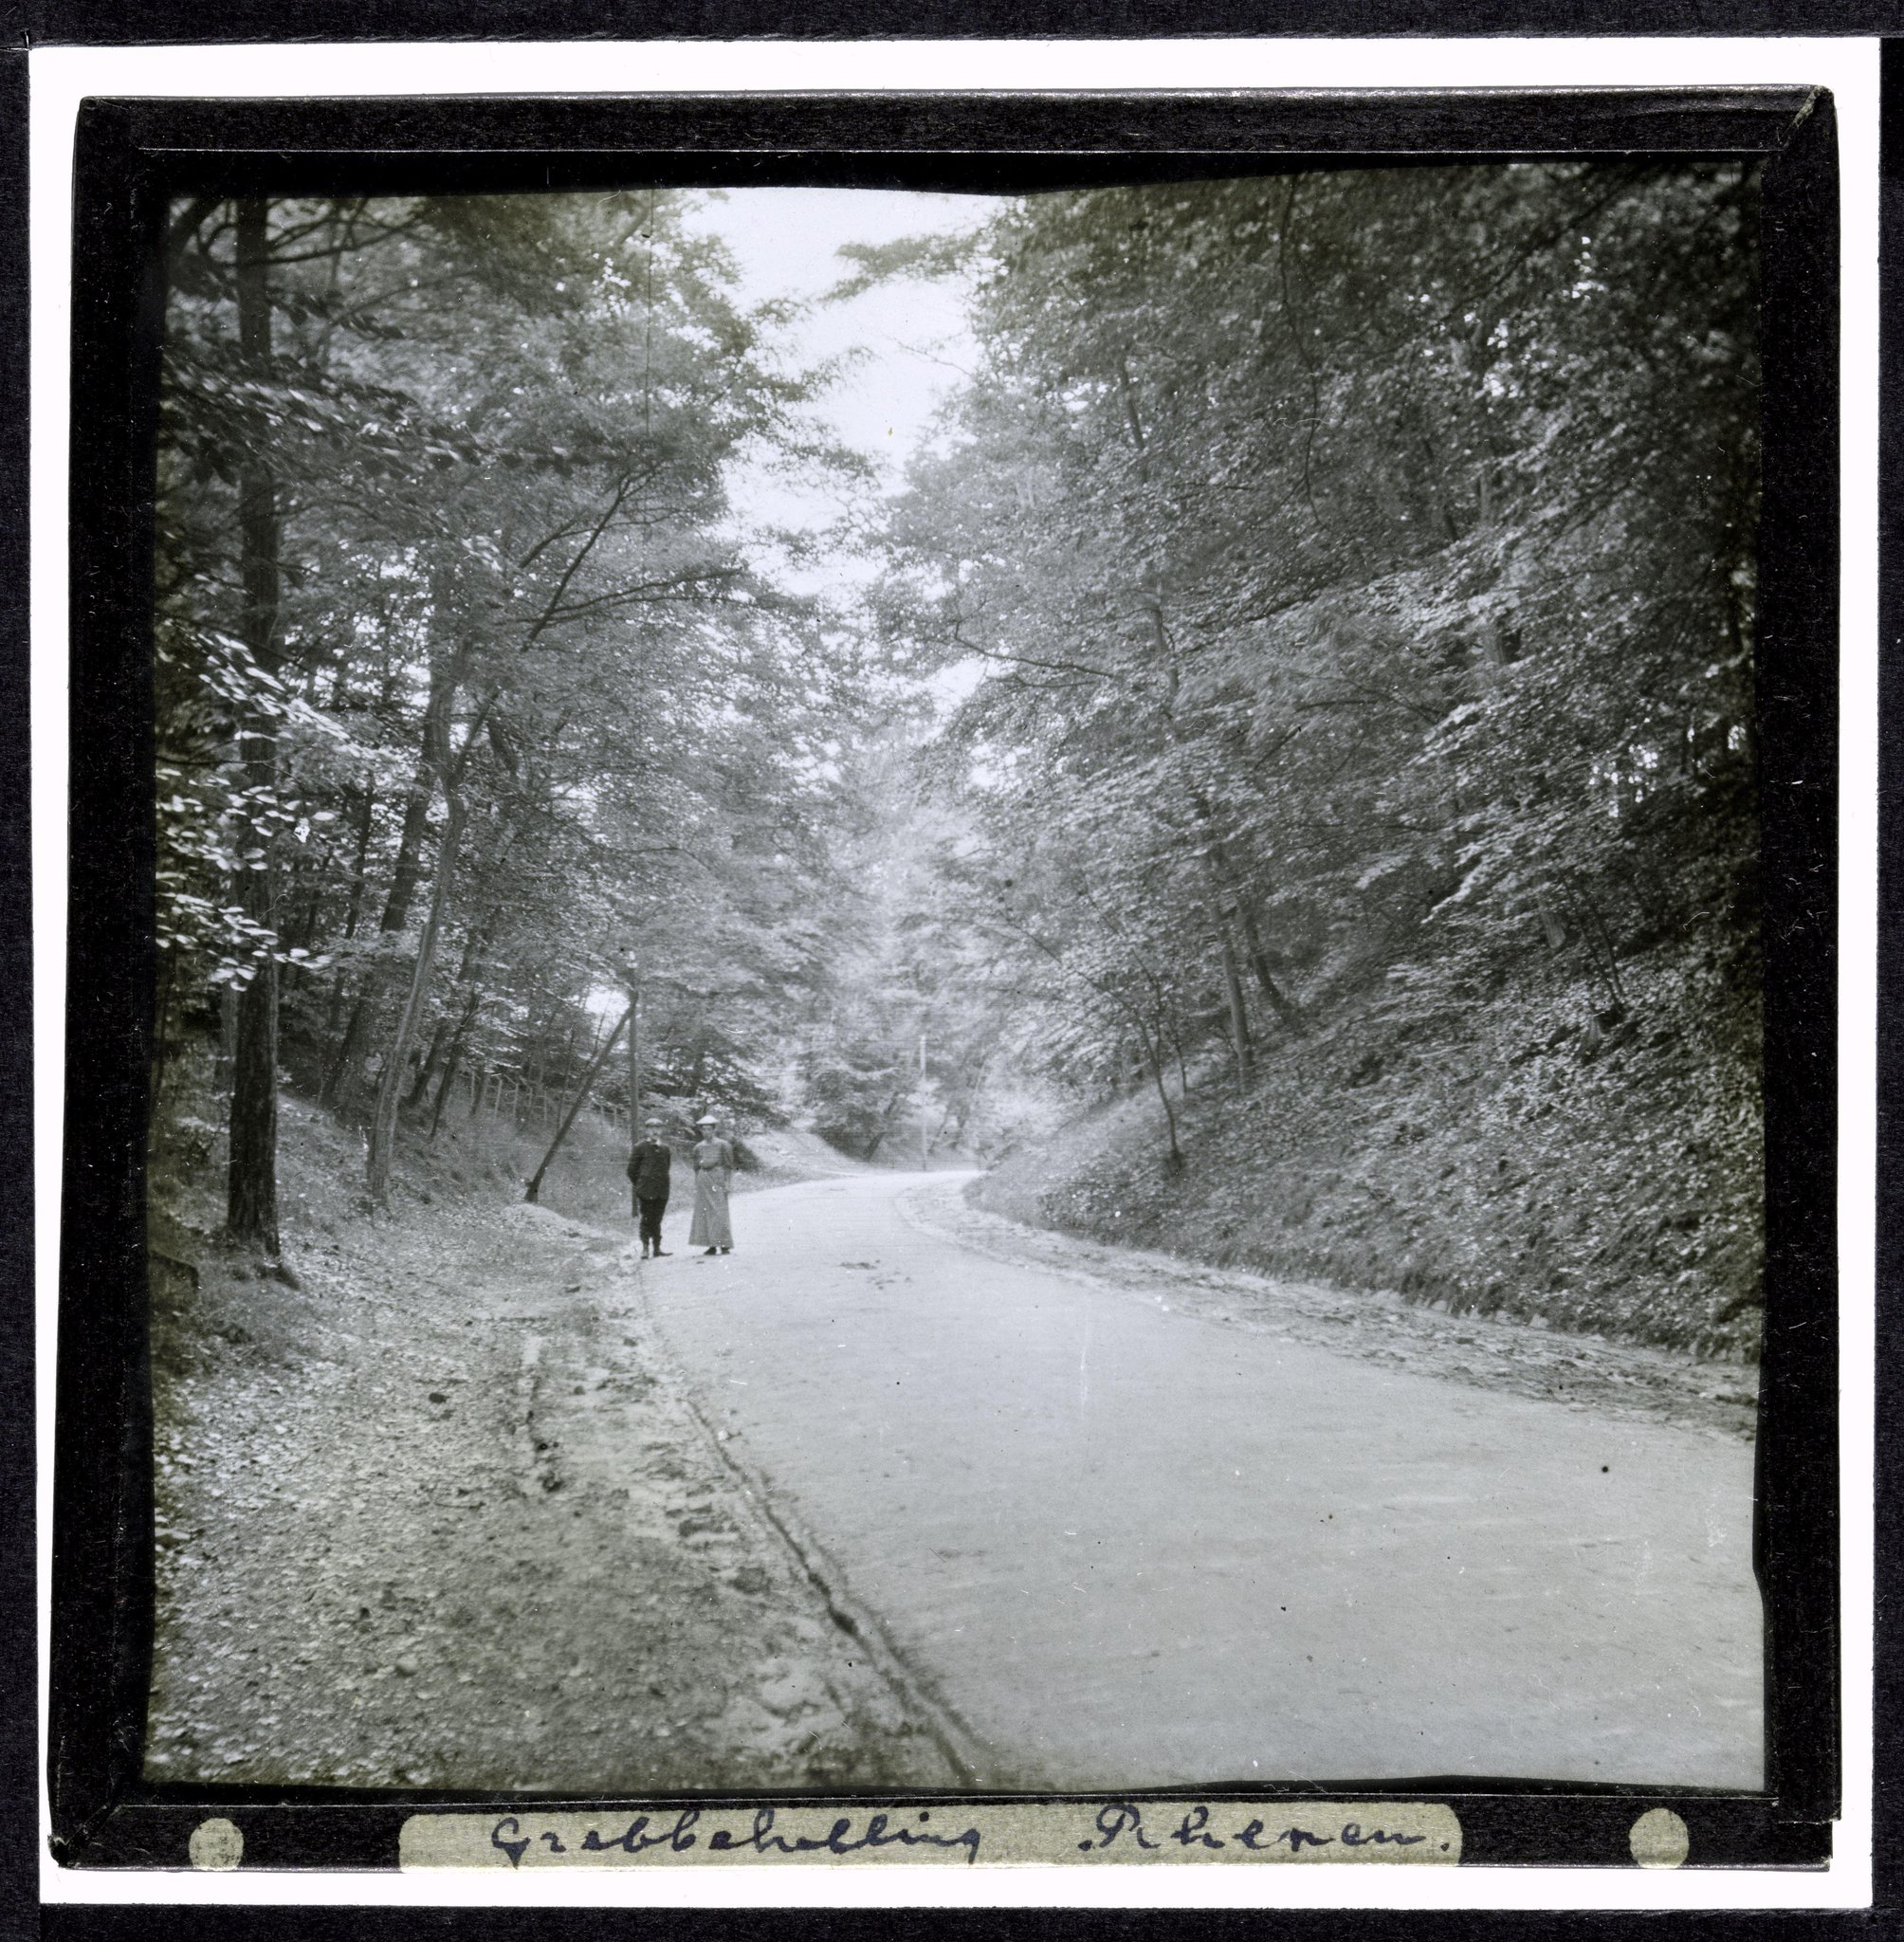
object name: glasdia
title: Twee mensen op een weg in het bos bij de Grebbeberg in Rhenen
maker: Anonymous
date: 1907-1935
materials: glass, ink, paper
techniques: slide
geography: rhenen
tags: forest path or lane, rhenen